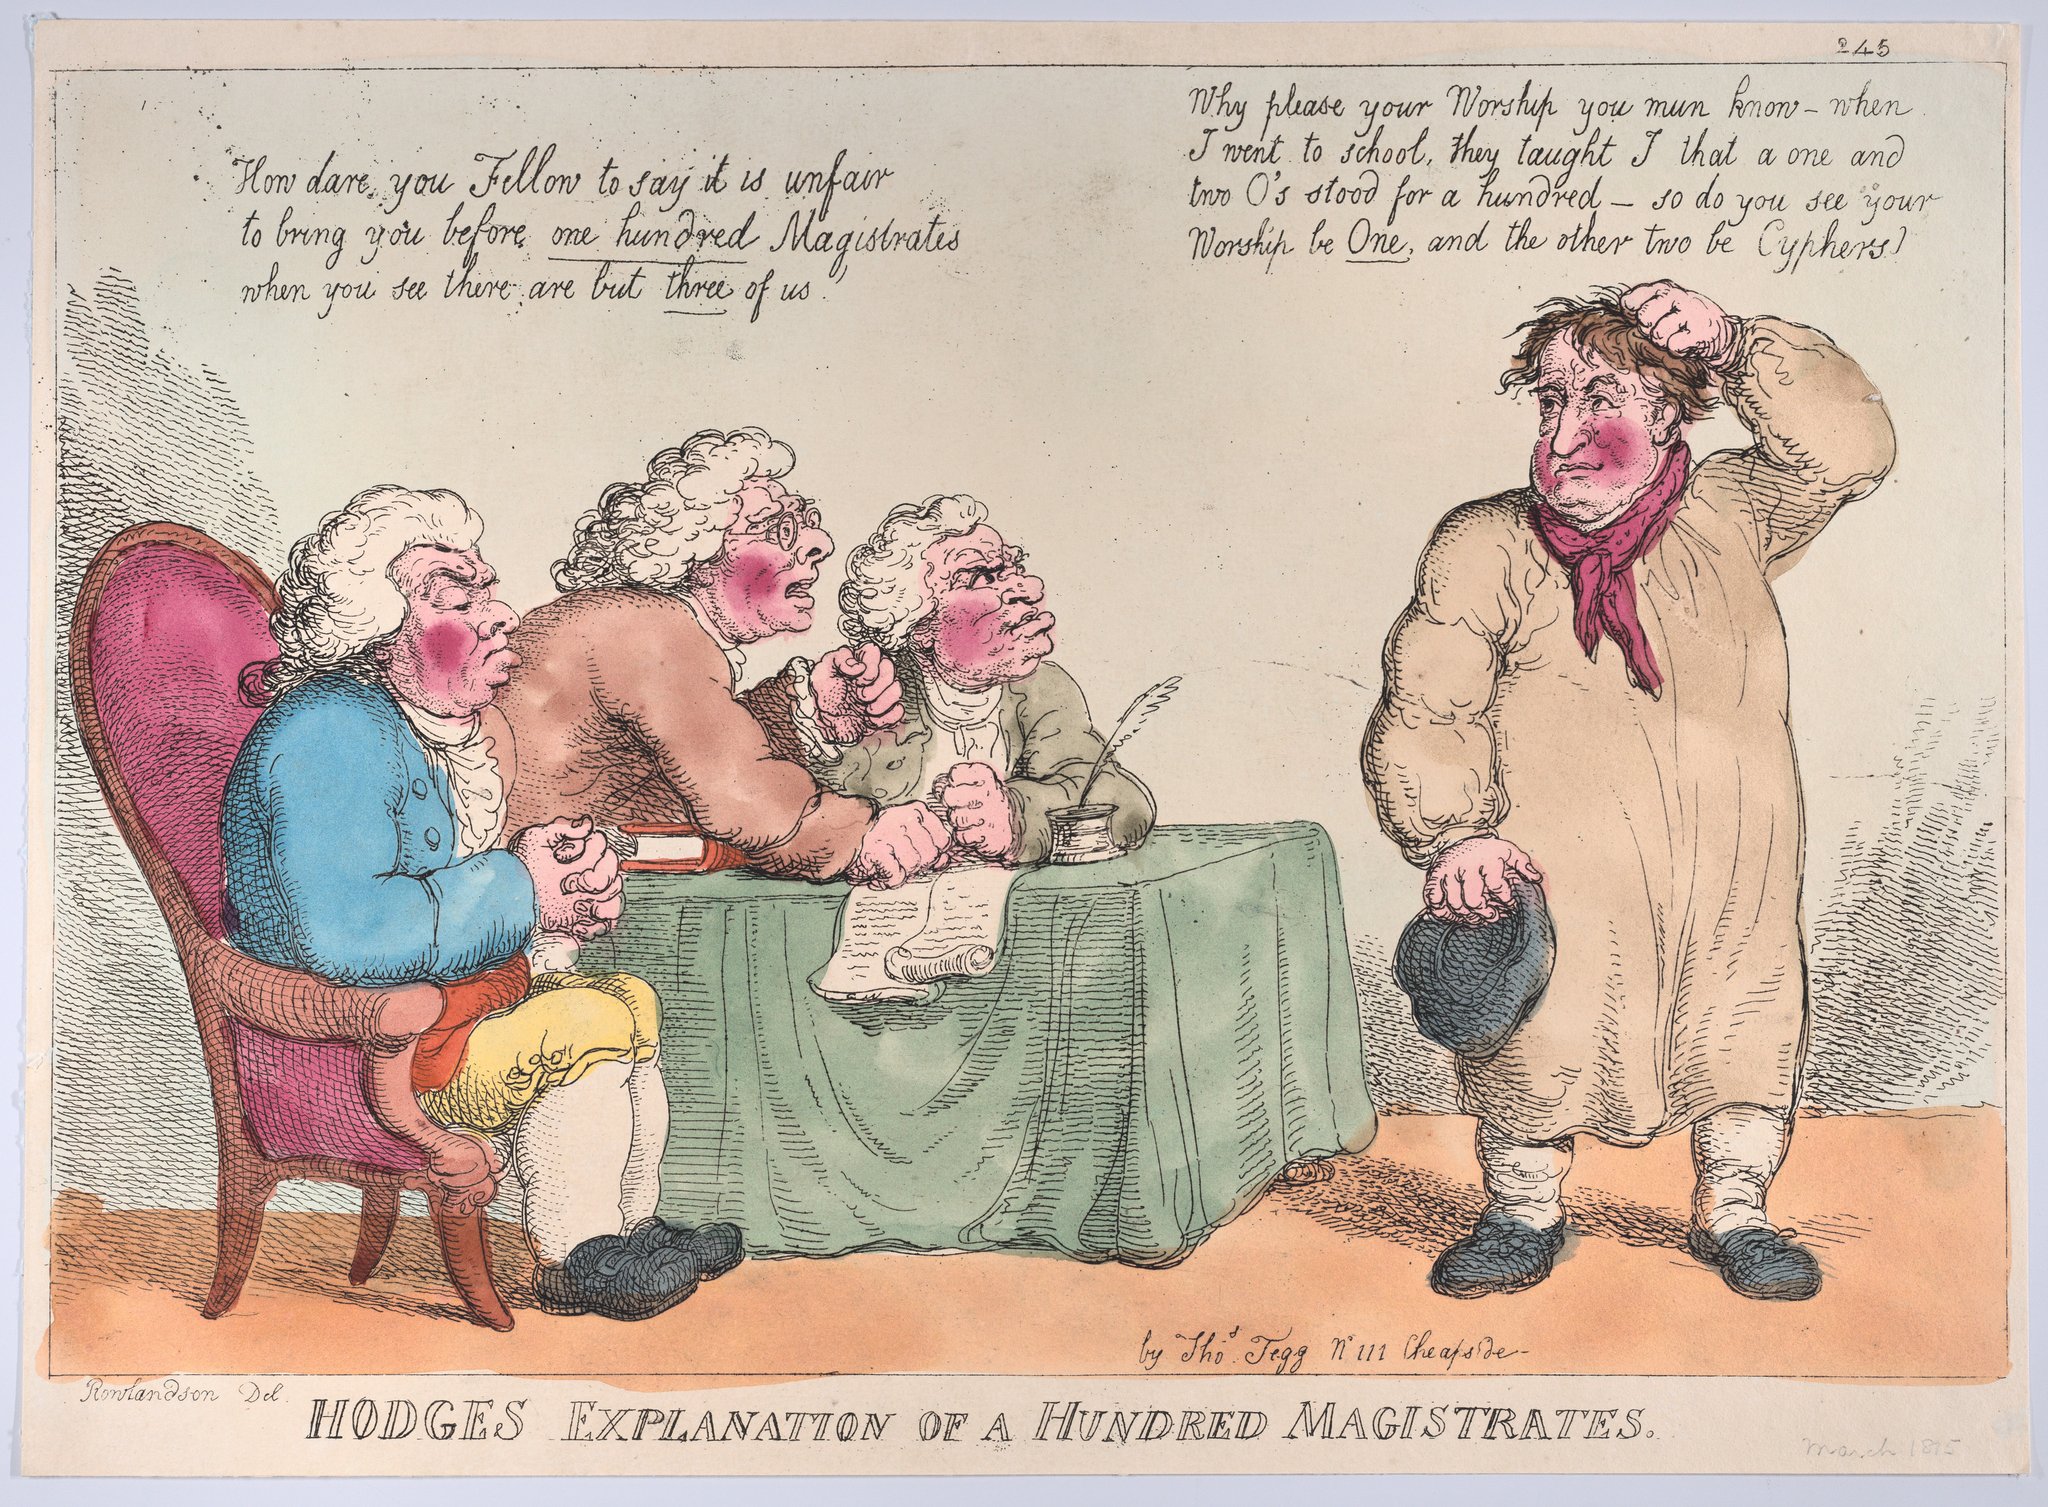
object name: print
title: Hodge's Explanation of a Hundred Magistrates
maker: thomas rowlandson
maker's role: artist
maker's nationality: british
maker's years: 1757-1827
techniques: etching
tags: satire,men